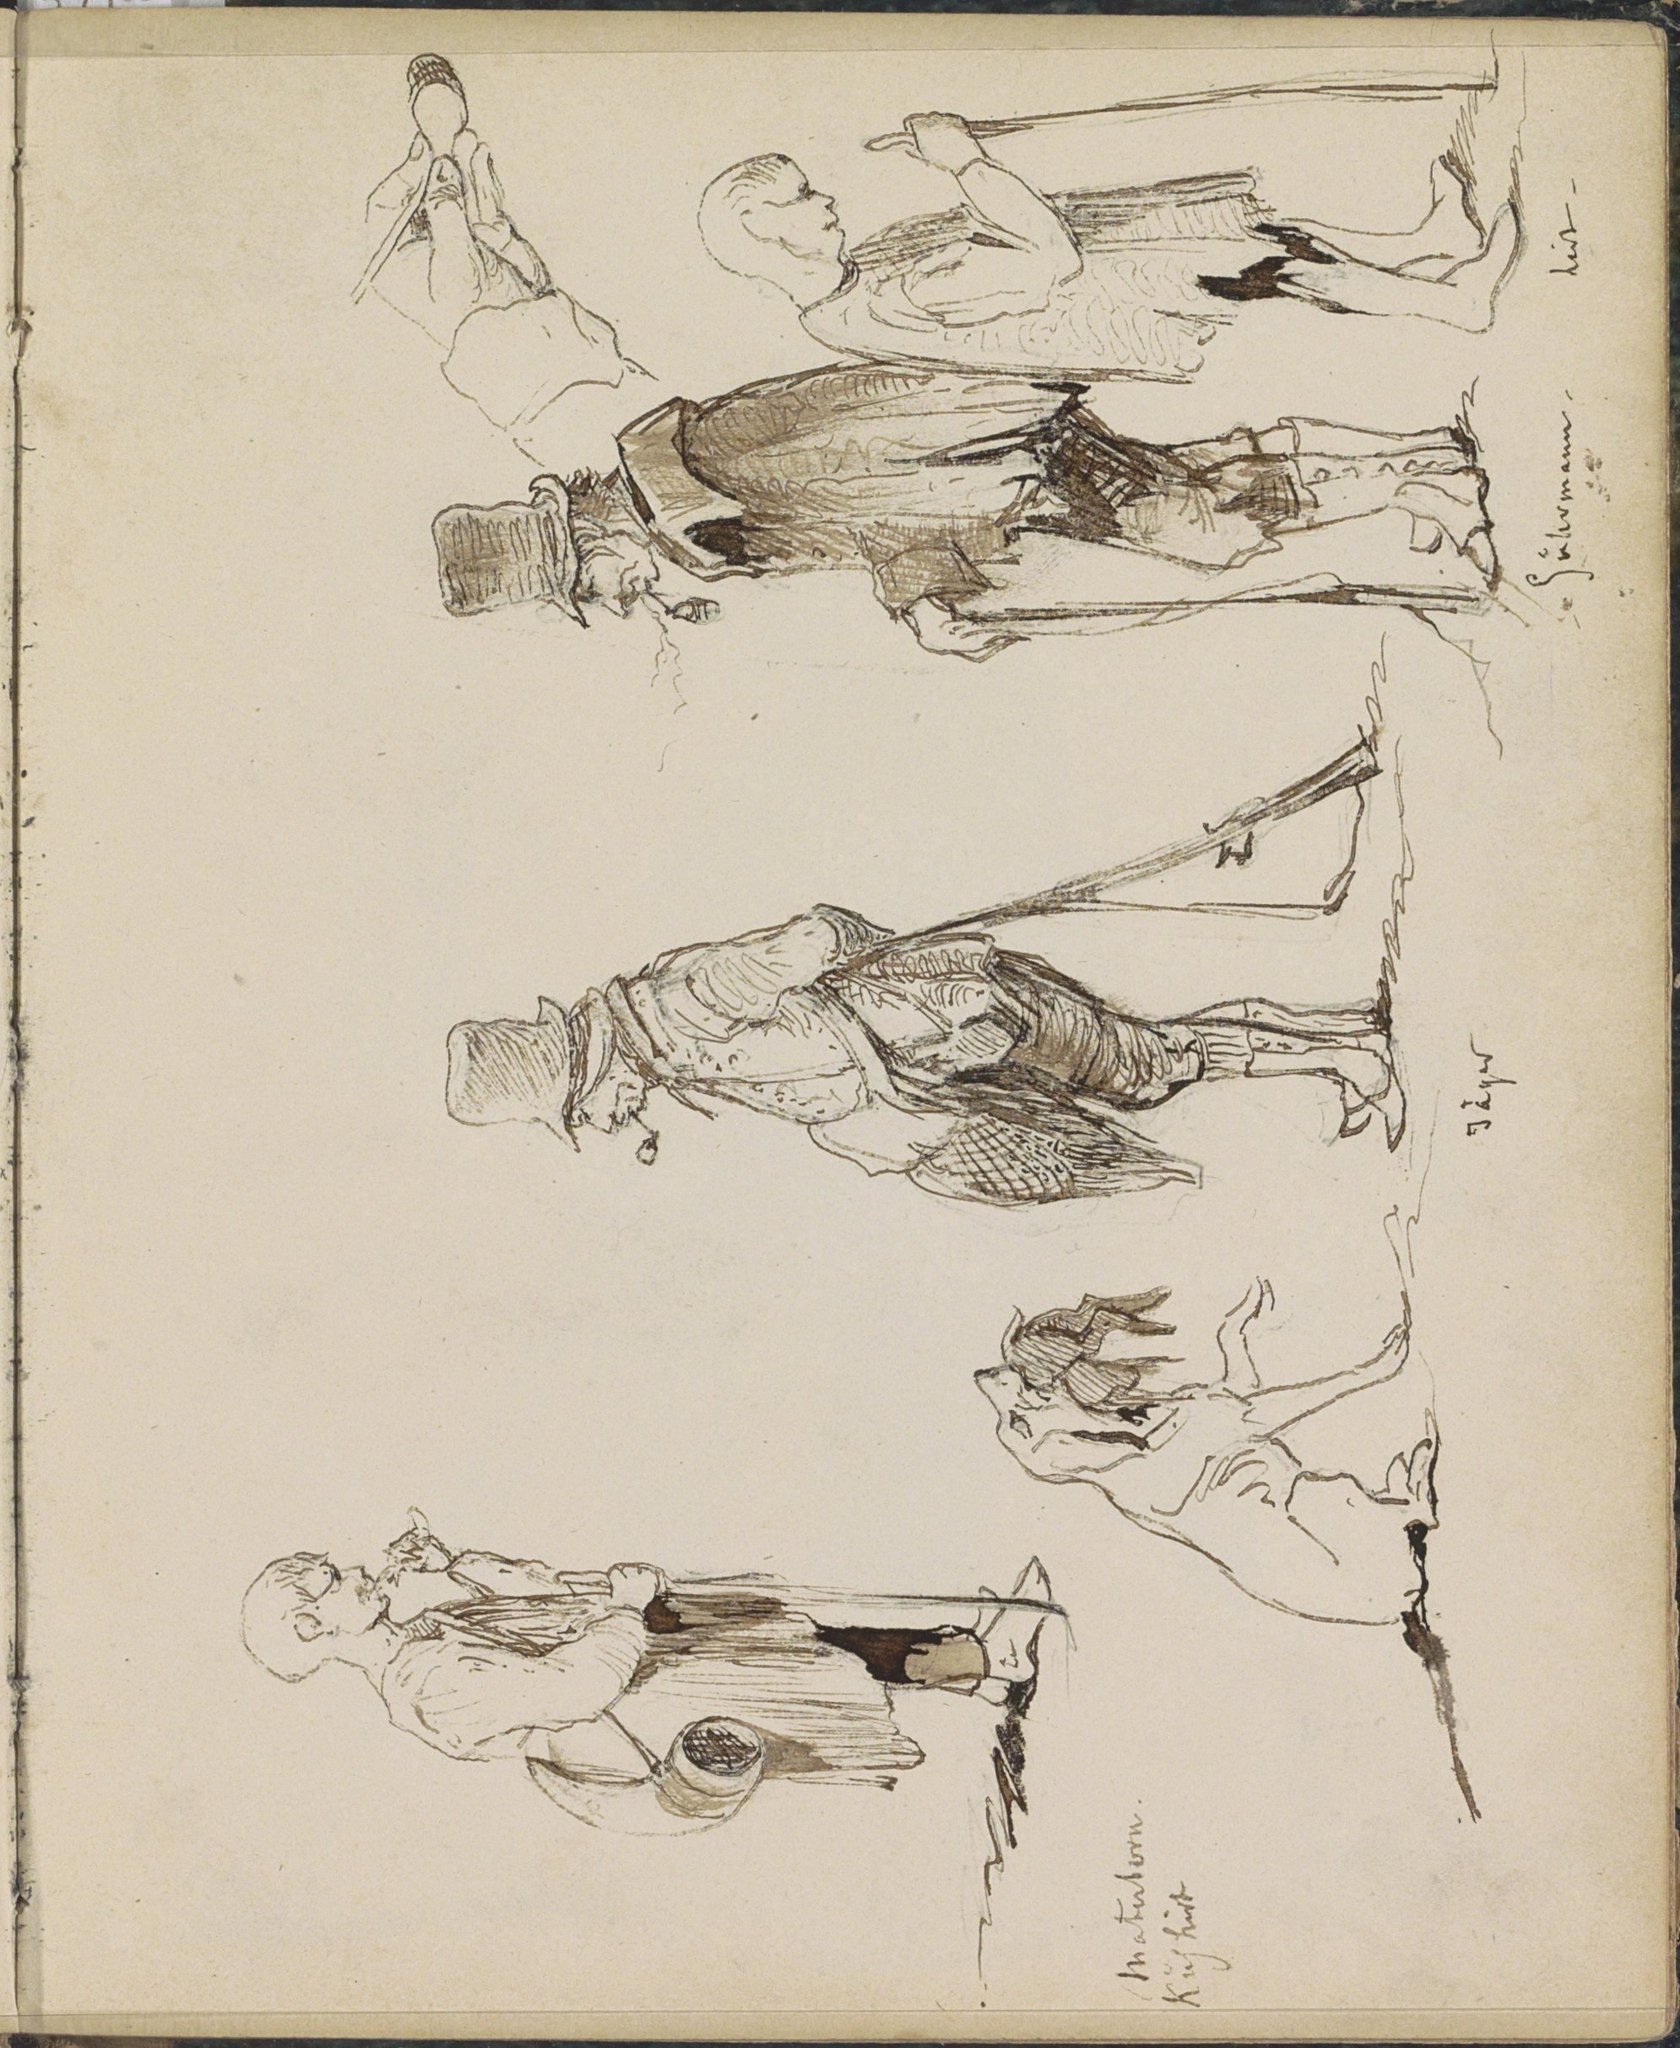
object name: sketchbook leaf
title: Jongen met een jachthoorn, jagers en een hand met een pijp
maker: johannes tavenraat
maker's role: draughtsman, painter, print maker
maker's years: 1809-1881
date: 1841-1853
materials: ink, paper, pencil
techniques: pen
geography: materborn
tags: boy (child between toddler and youth), walking-stick, staff, hunter, pipe ~ tobacco, hunting horn, dog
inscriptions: annotation: ‘Materborn./ Kü[...]hirt/ Jäger/ [...]ürhrmann/ h[...]it’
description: Tevens studies van een hond met een haas in de bek en een jongen met een houten (wandel)stok.Pagina 51 recto uit een schetsboek met 87 bladen.